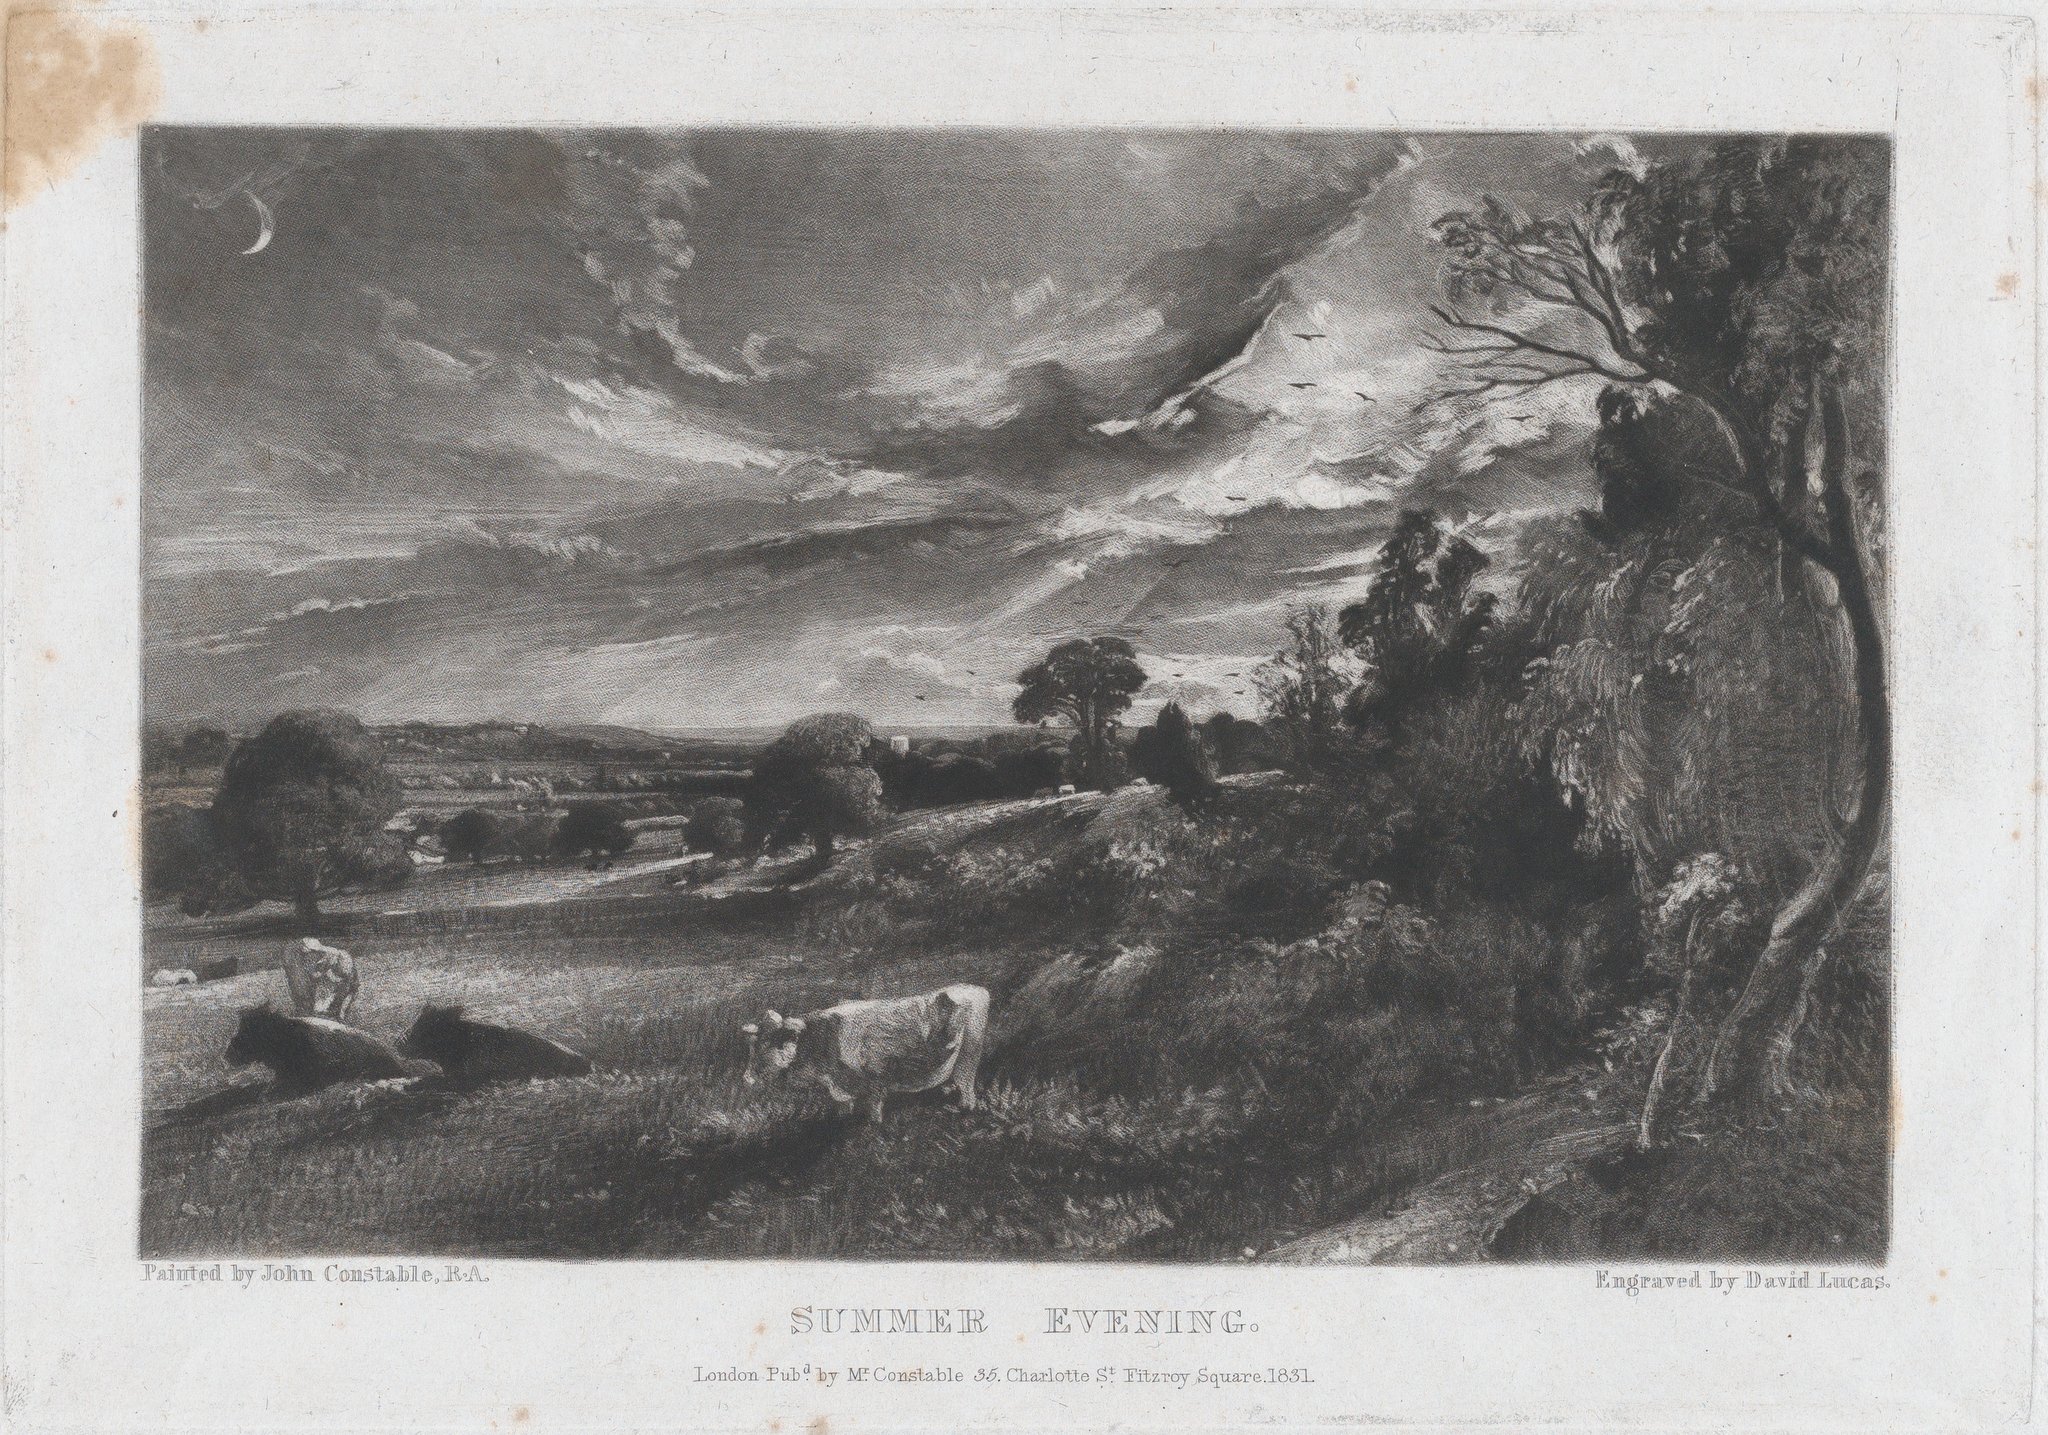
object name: print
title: Summer Evening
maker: david lucas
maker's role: artist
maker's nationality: british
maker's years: 1802-1881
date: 1831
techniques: mezzotint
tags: cows,landscapes,summer,evening